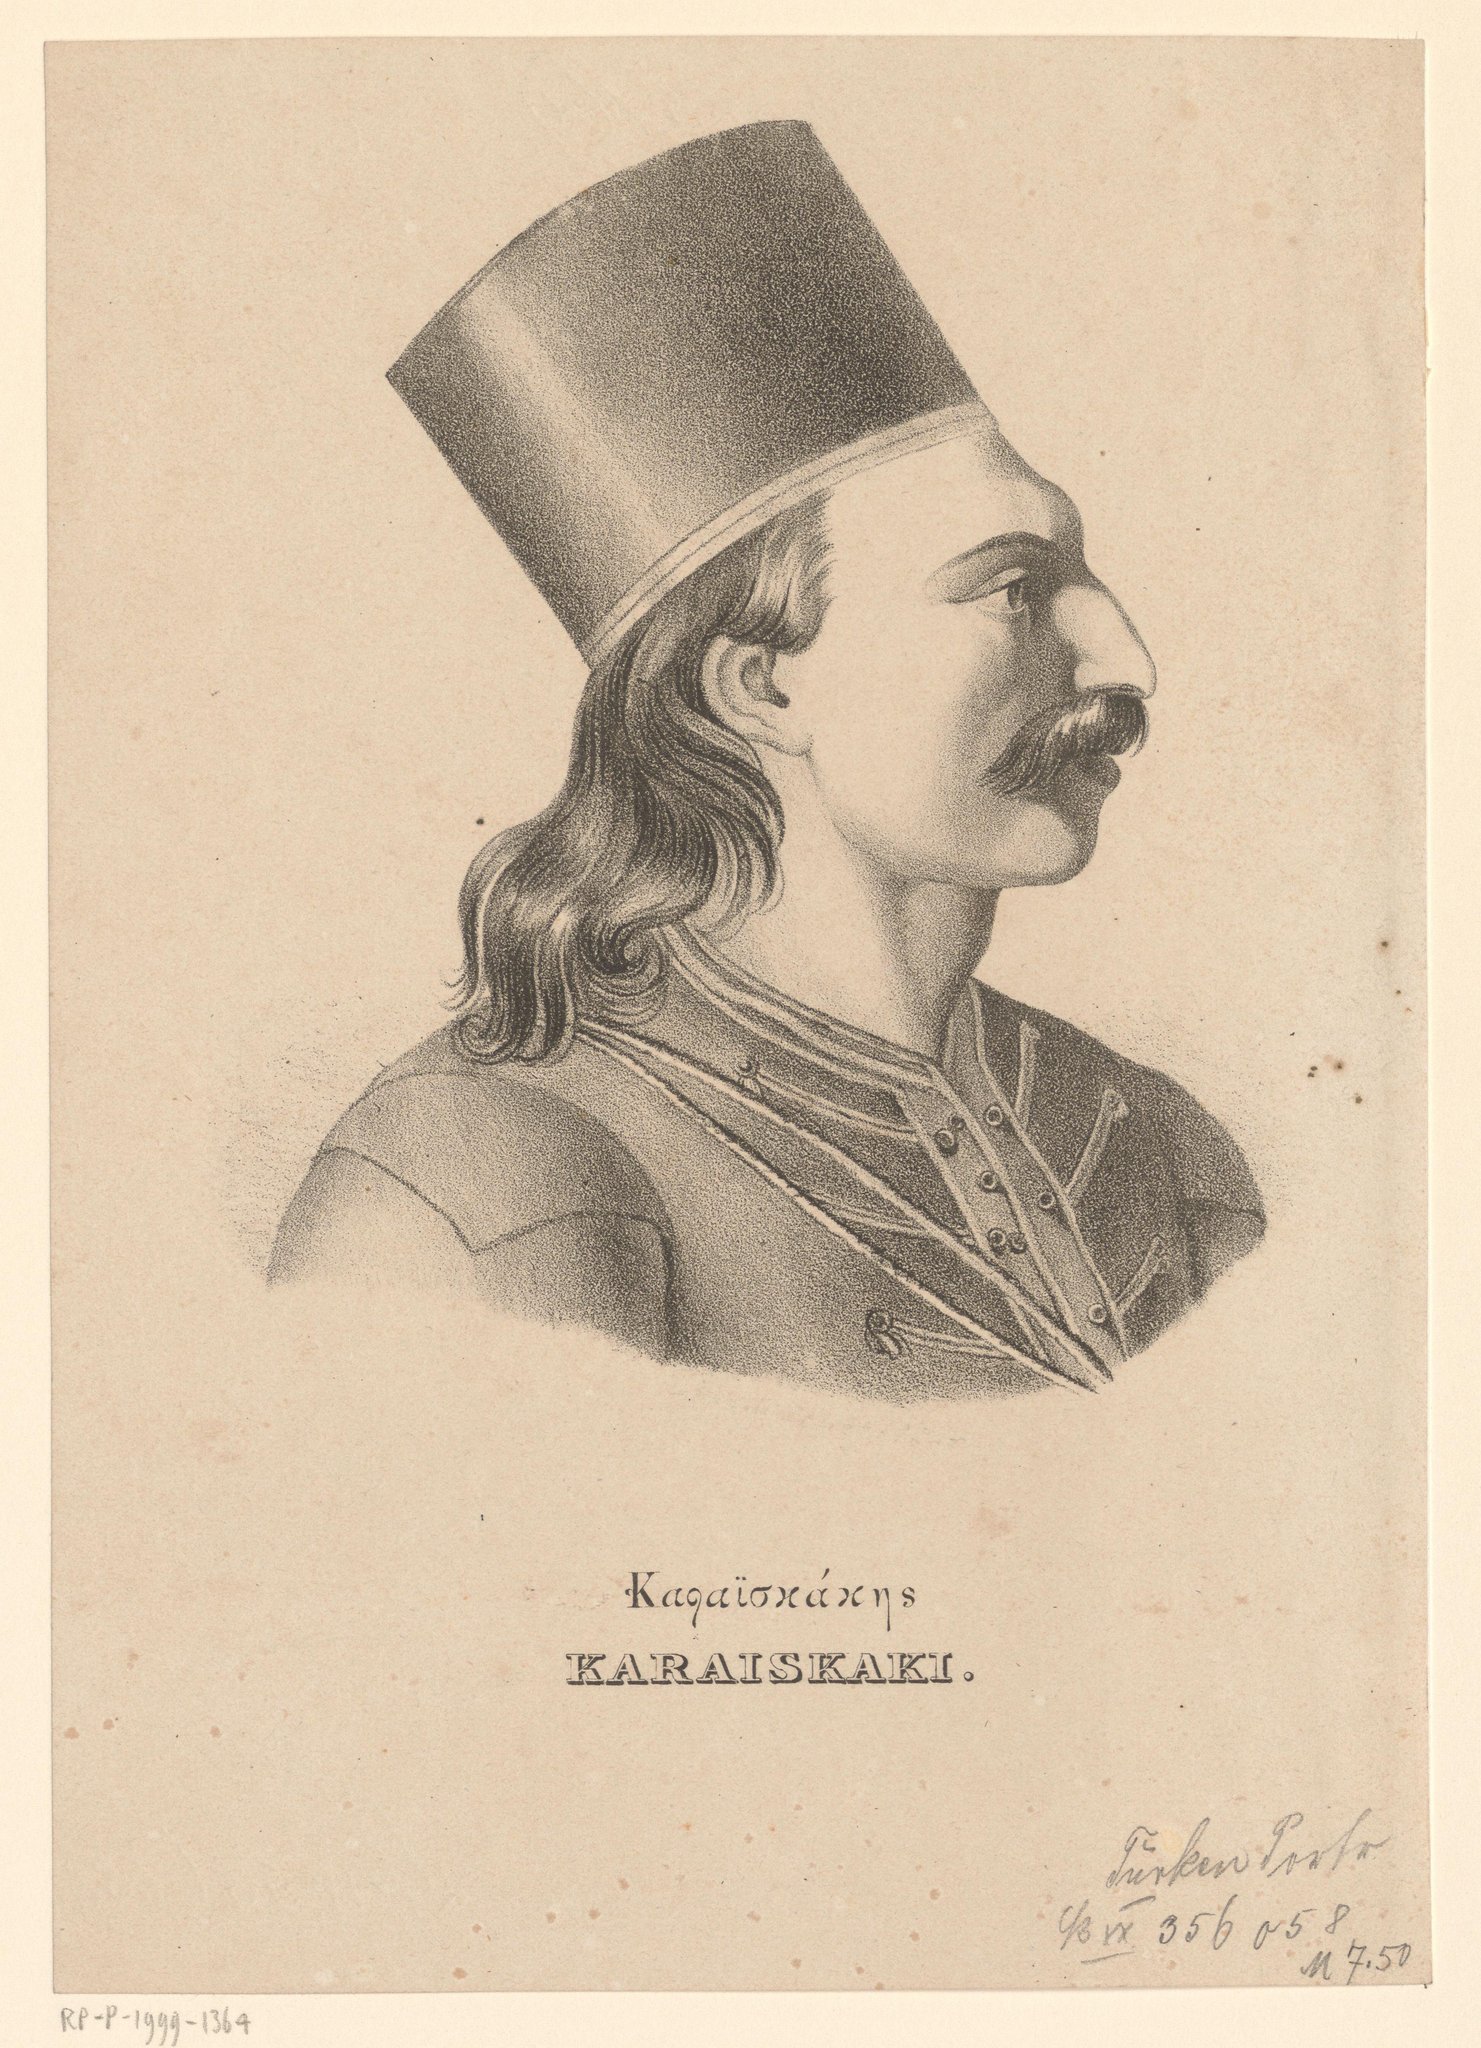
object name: print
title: Portret van Karaiskaki Girgir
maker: Anonymous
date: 1800-1900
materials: paper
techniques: lithograph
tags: historical persons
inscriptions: collector's mark: Lugt 2228, collector's mark: Lugt 2760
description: Naam van geportretteerde in het Grieks in de ondermarge.